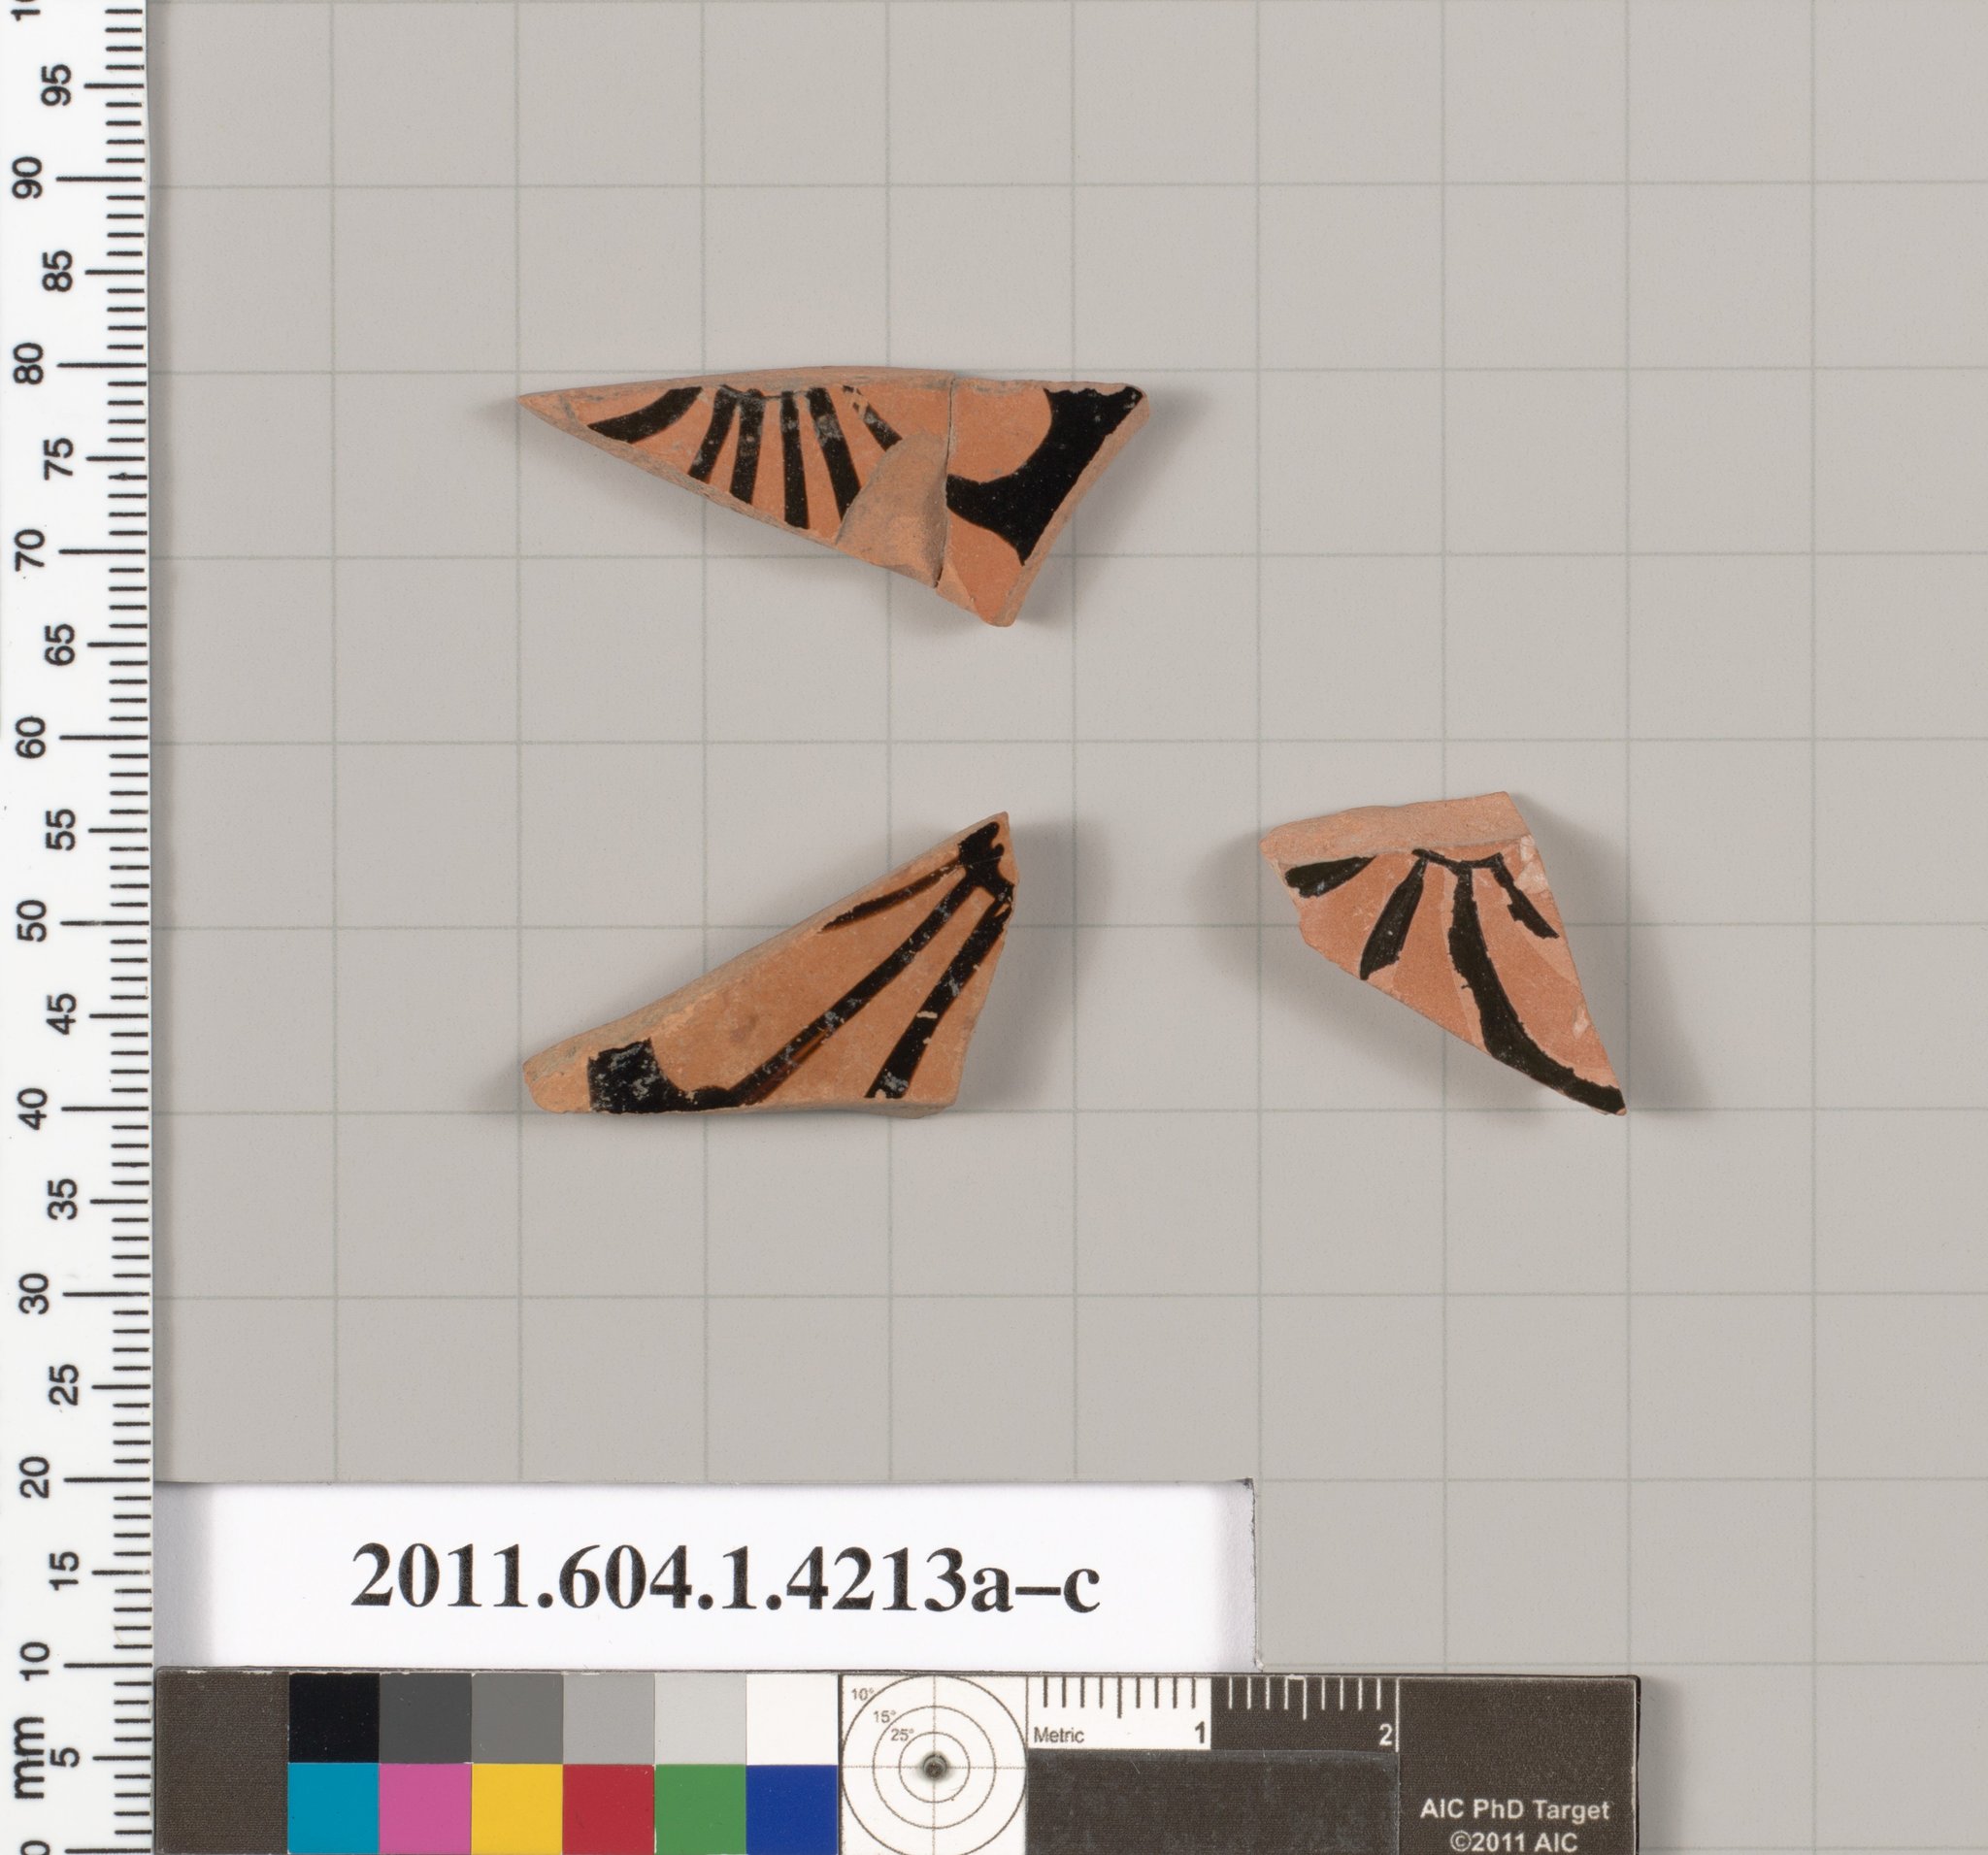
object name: kylix fragment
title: Terracotta fragments of kylikes (drinking cups)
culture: greek, attic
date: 475-451 BCE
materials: terracotta